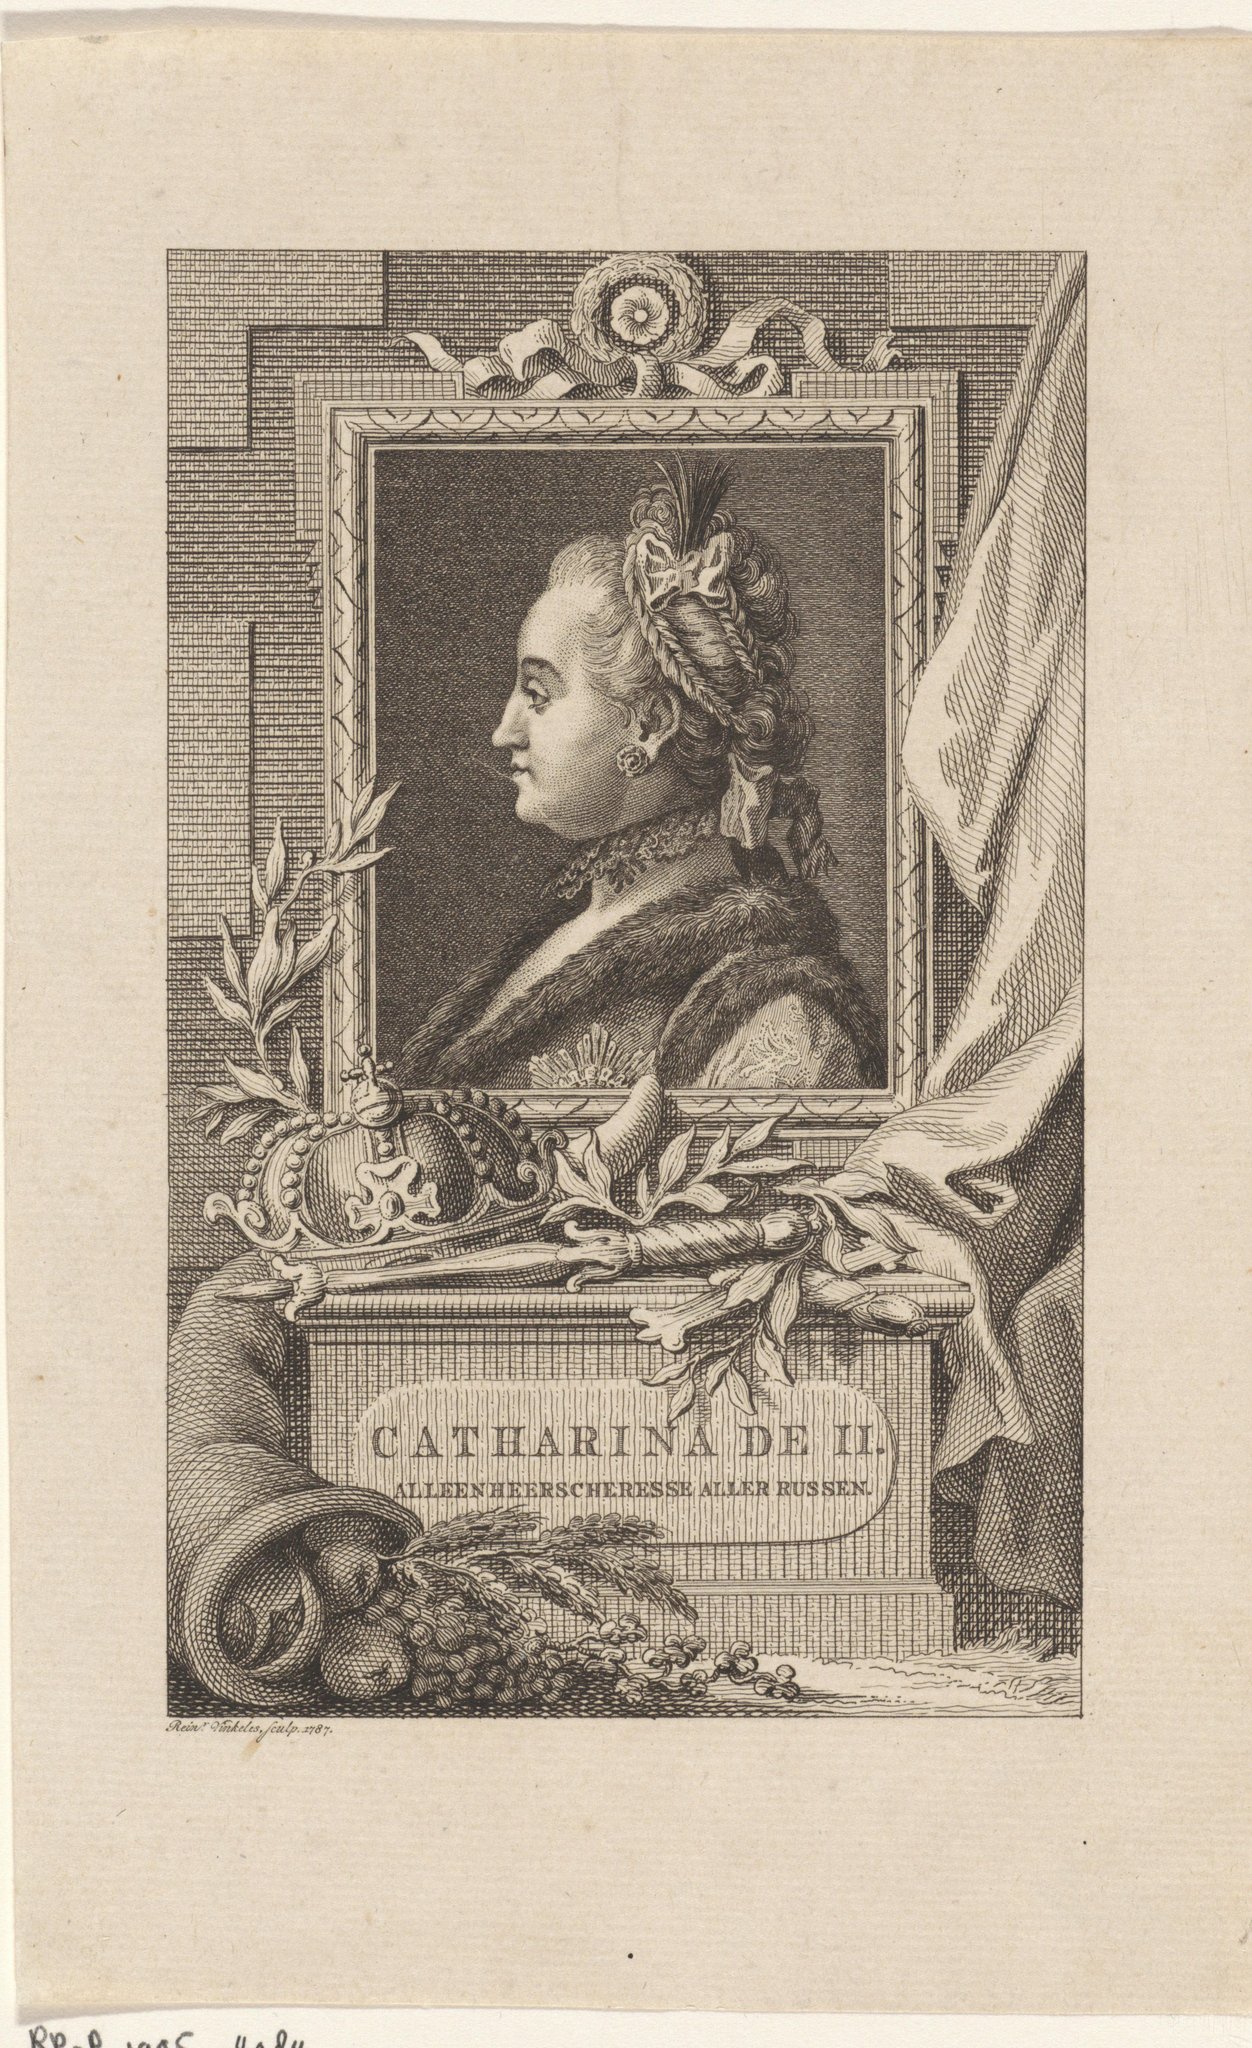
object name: print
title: Portret van Catharina de Grote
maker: reinier vinkeles (i)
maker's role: draughtsman, print maker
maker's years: 1741-1816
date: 1787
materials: paper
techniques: engraving, etching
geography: amsterdam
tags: sceptre, staff (symbol of sovereignty) - bb - female ruler, crown (symbol of sovereignty) - bb - female ruler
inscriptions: collector's mark: Lugt 2228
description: Portret van Catharina de Grote, met voor het portret tsarenkroon en scepter.